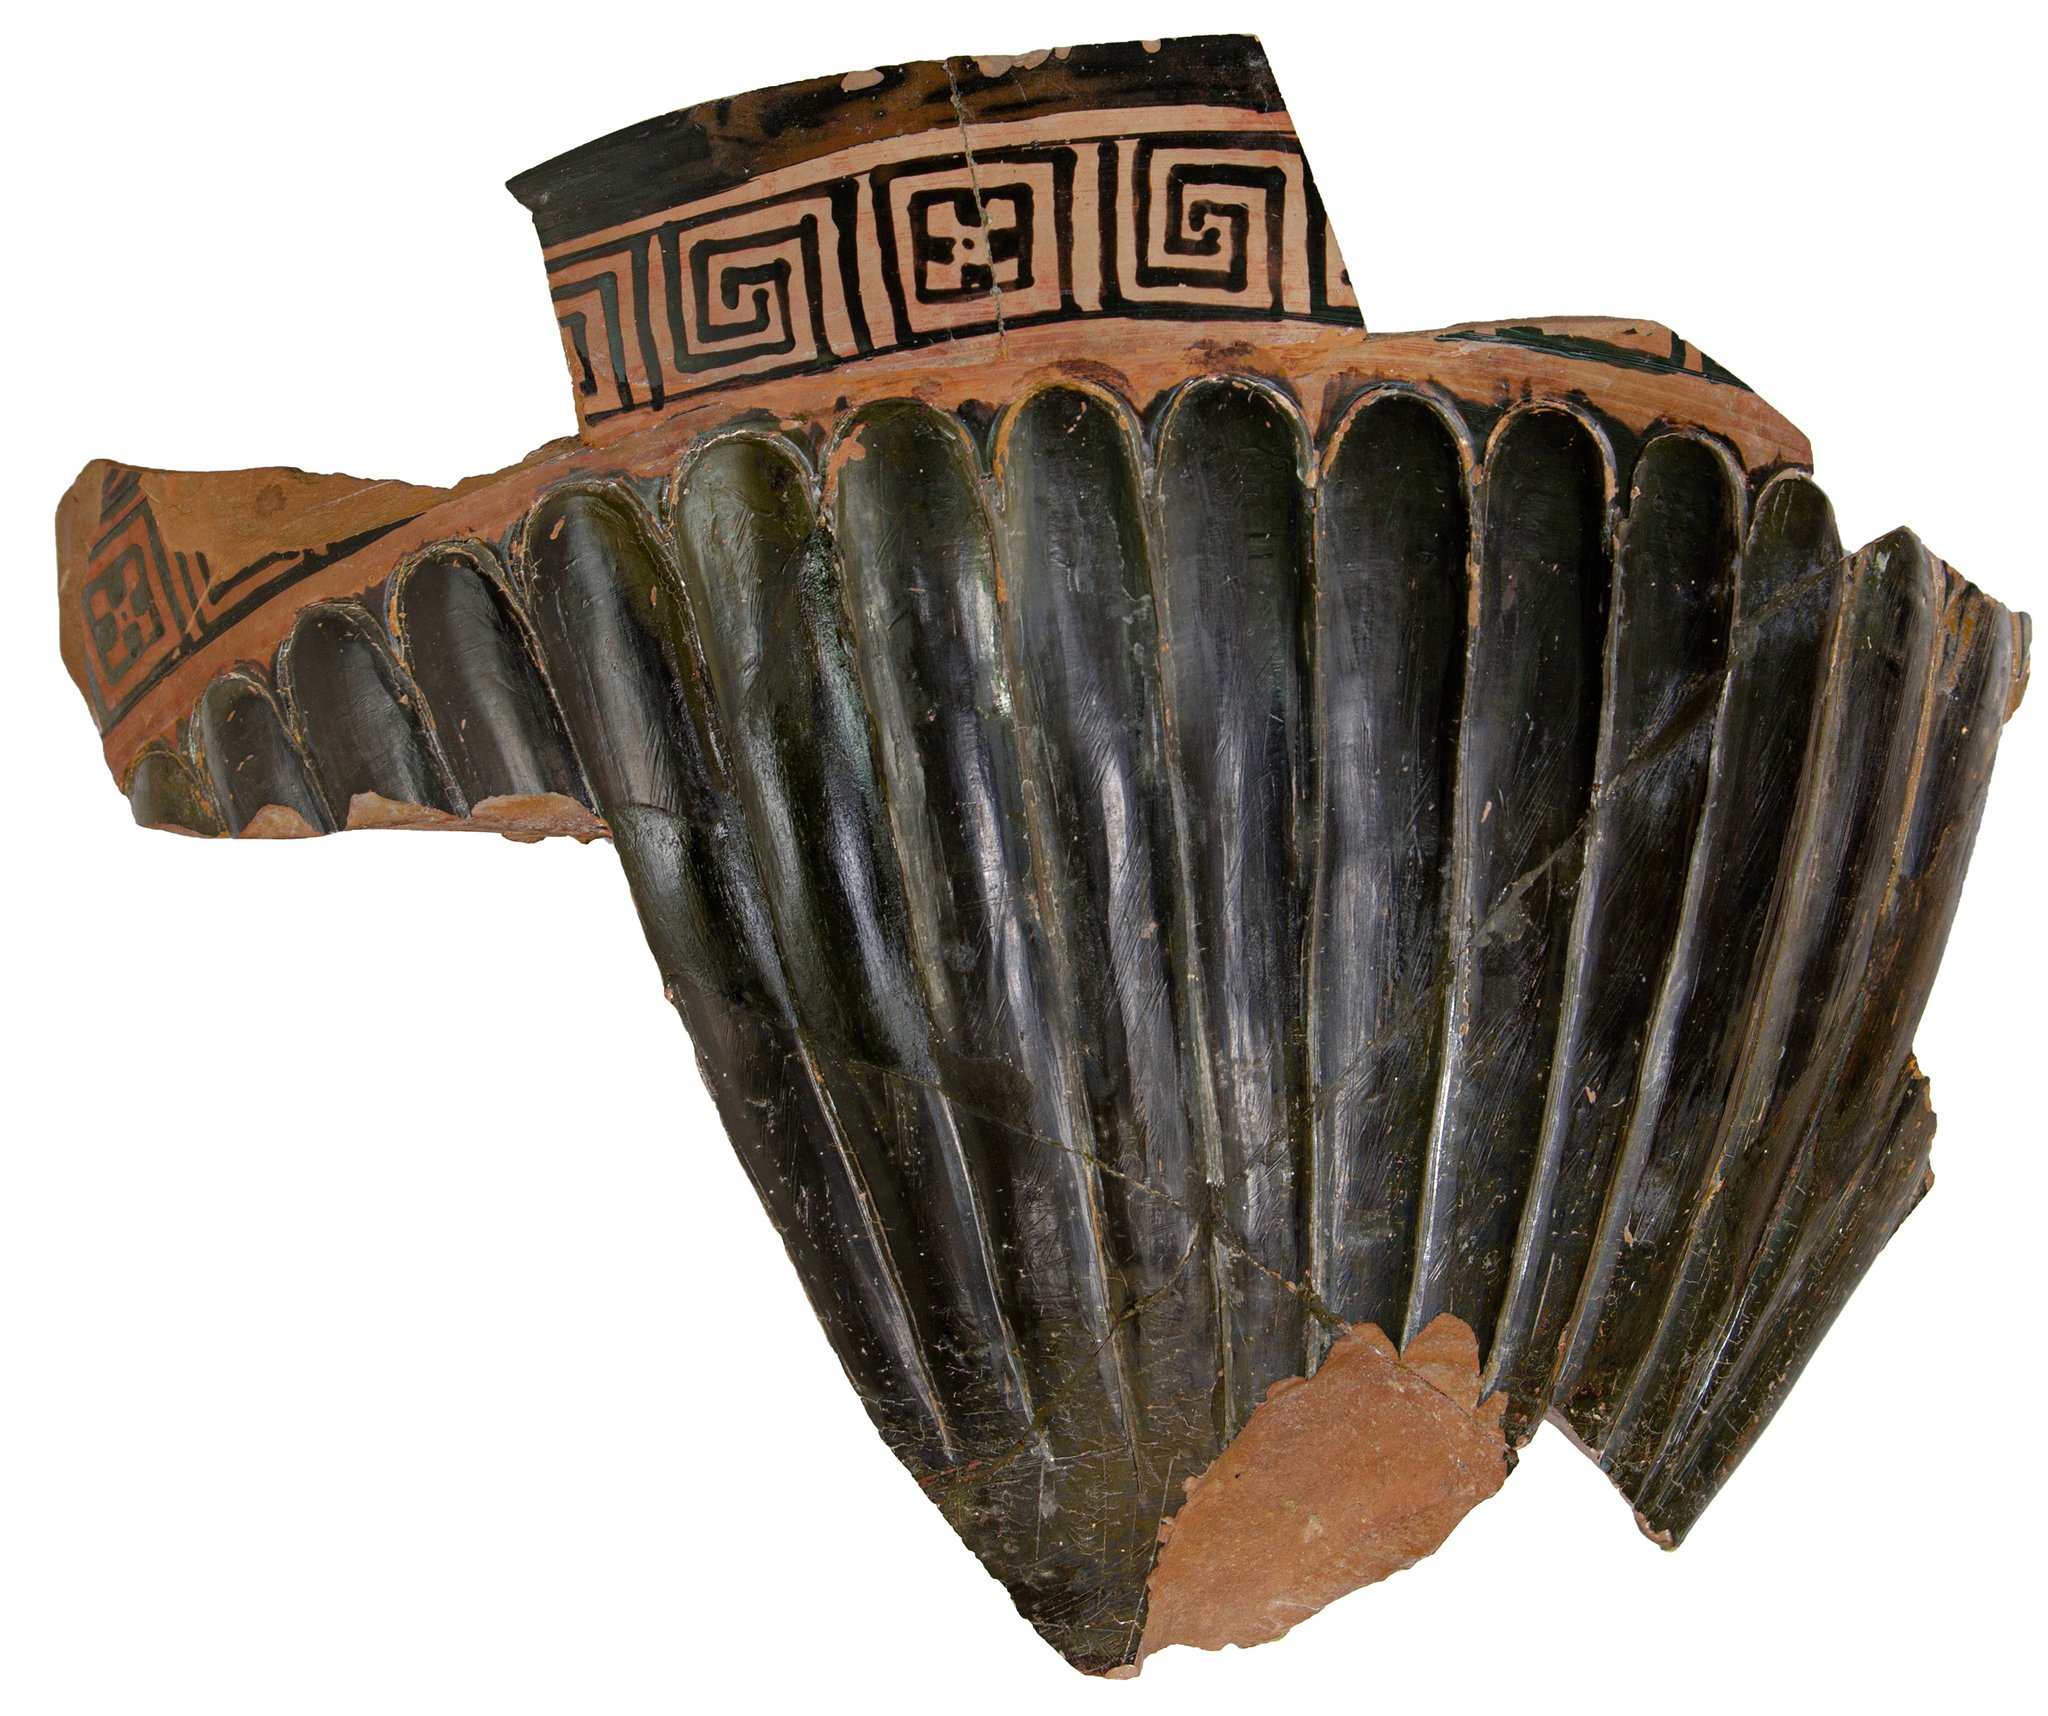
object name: volute krater fragment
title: Volute-krater fragment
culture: greek, south italian, apulian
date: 400-350 BCE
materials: terracotta